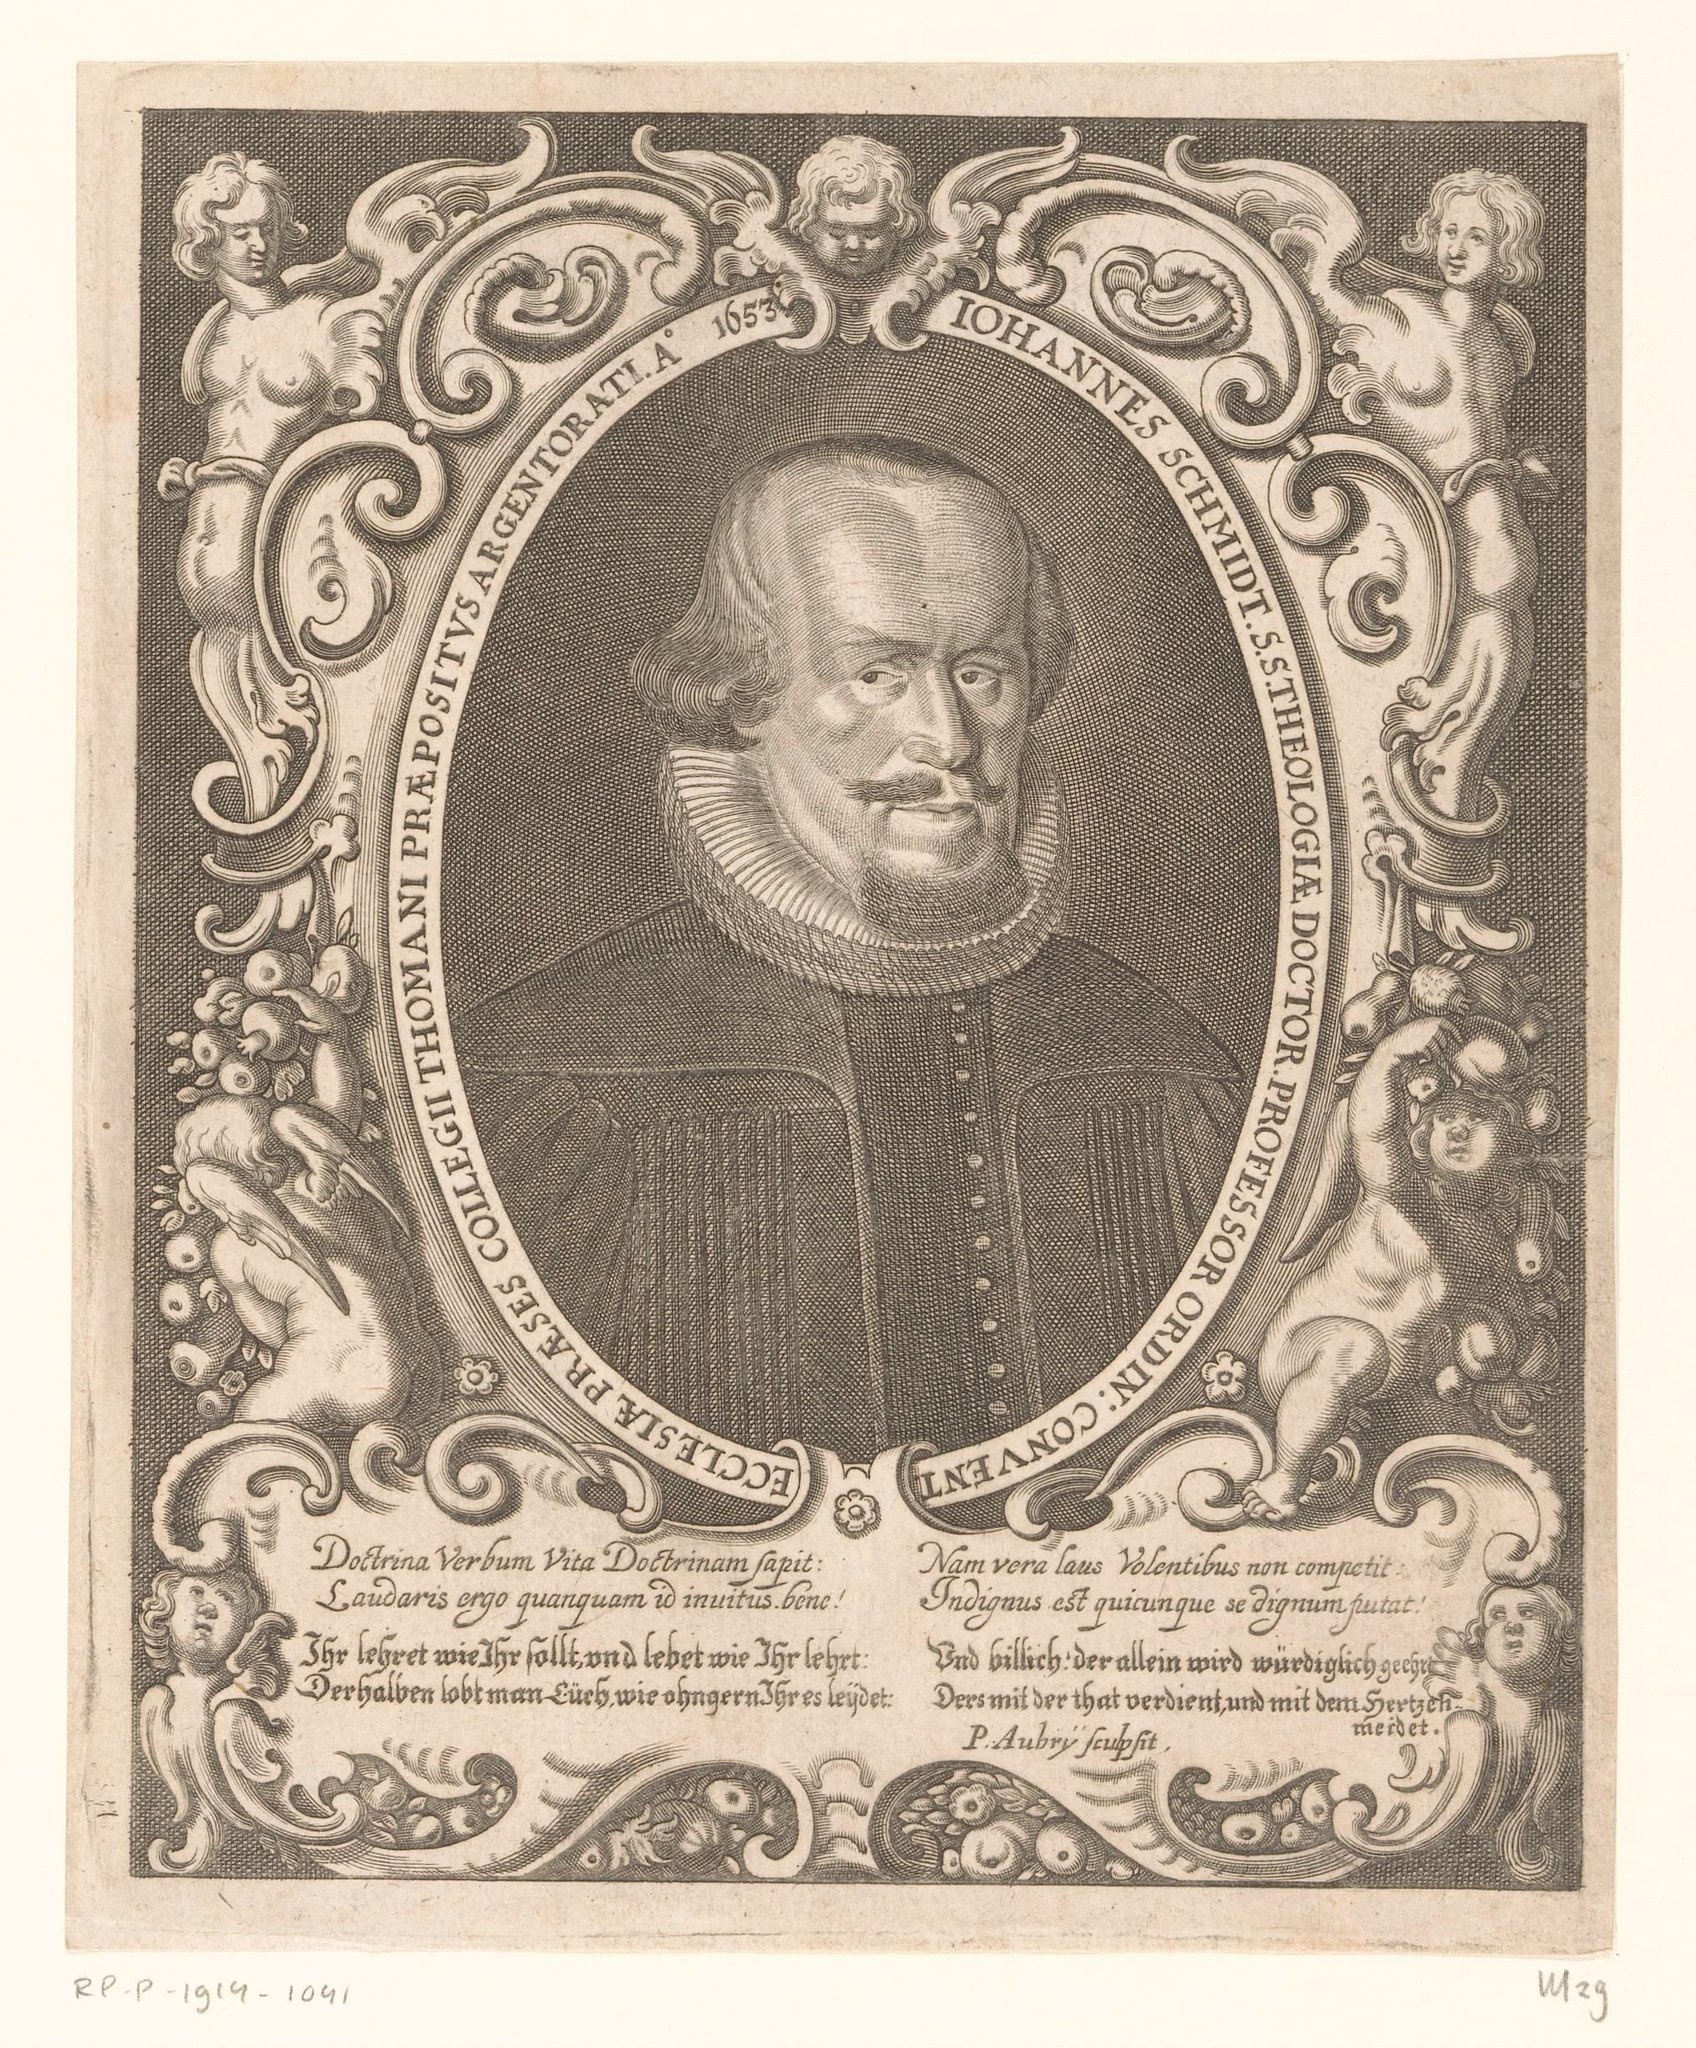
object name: print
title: Portret van Johann Schmidt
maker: peter aubry (iii)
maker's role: print maker, publisher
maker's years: 1610-1686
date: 1653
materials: paper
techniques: engraving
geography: straatsburg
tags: johann schmidt, historical persons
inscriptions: collector's mark: Lugt 2228